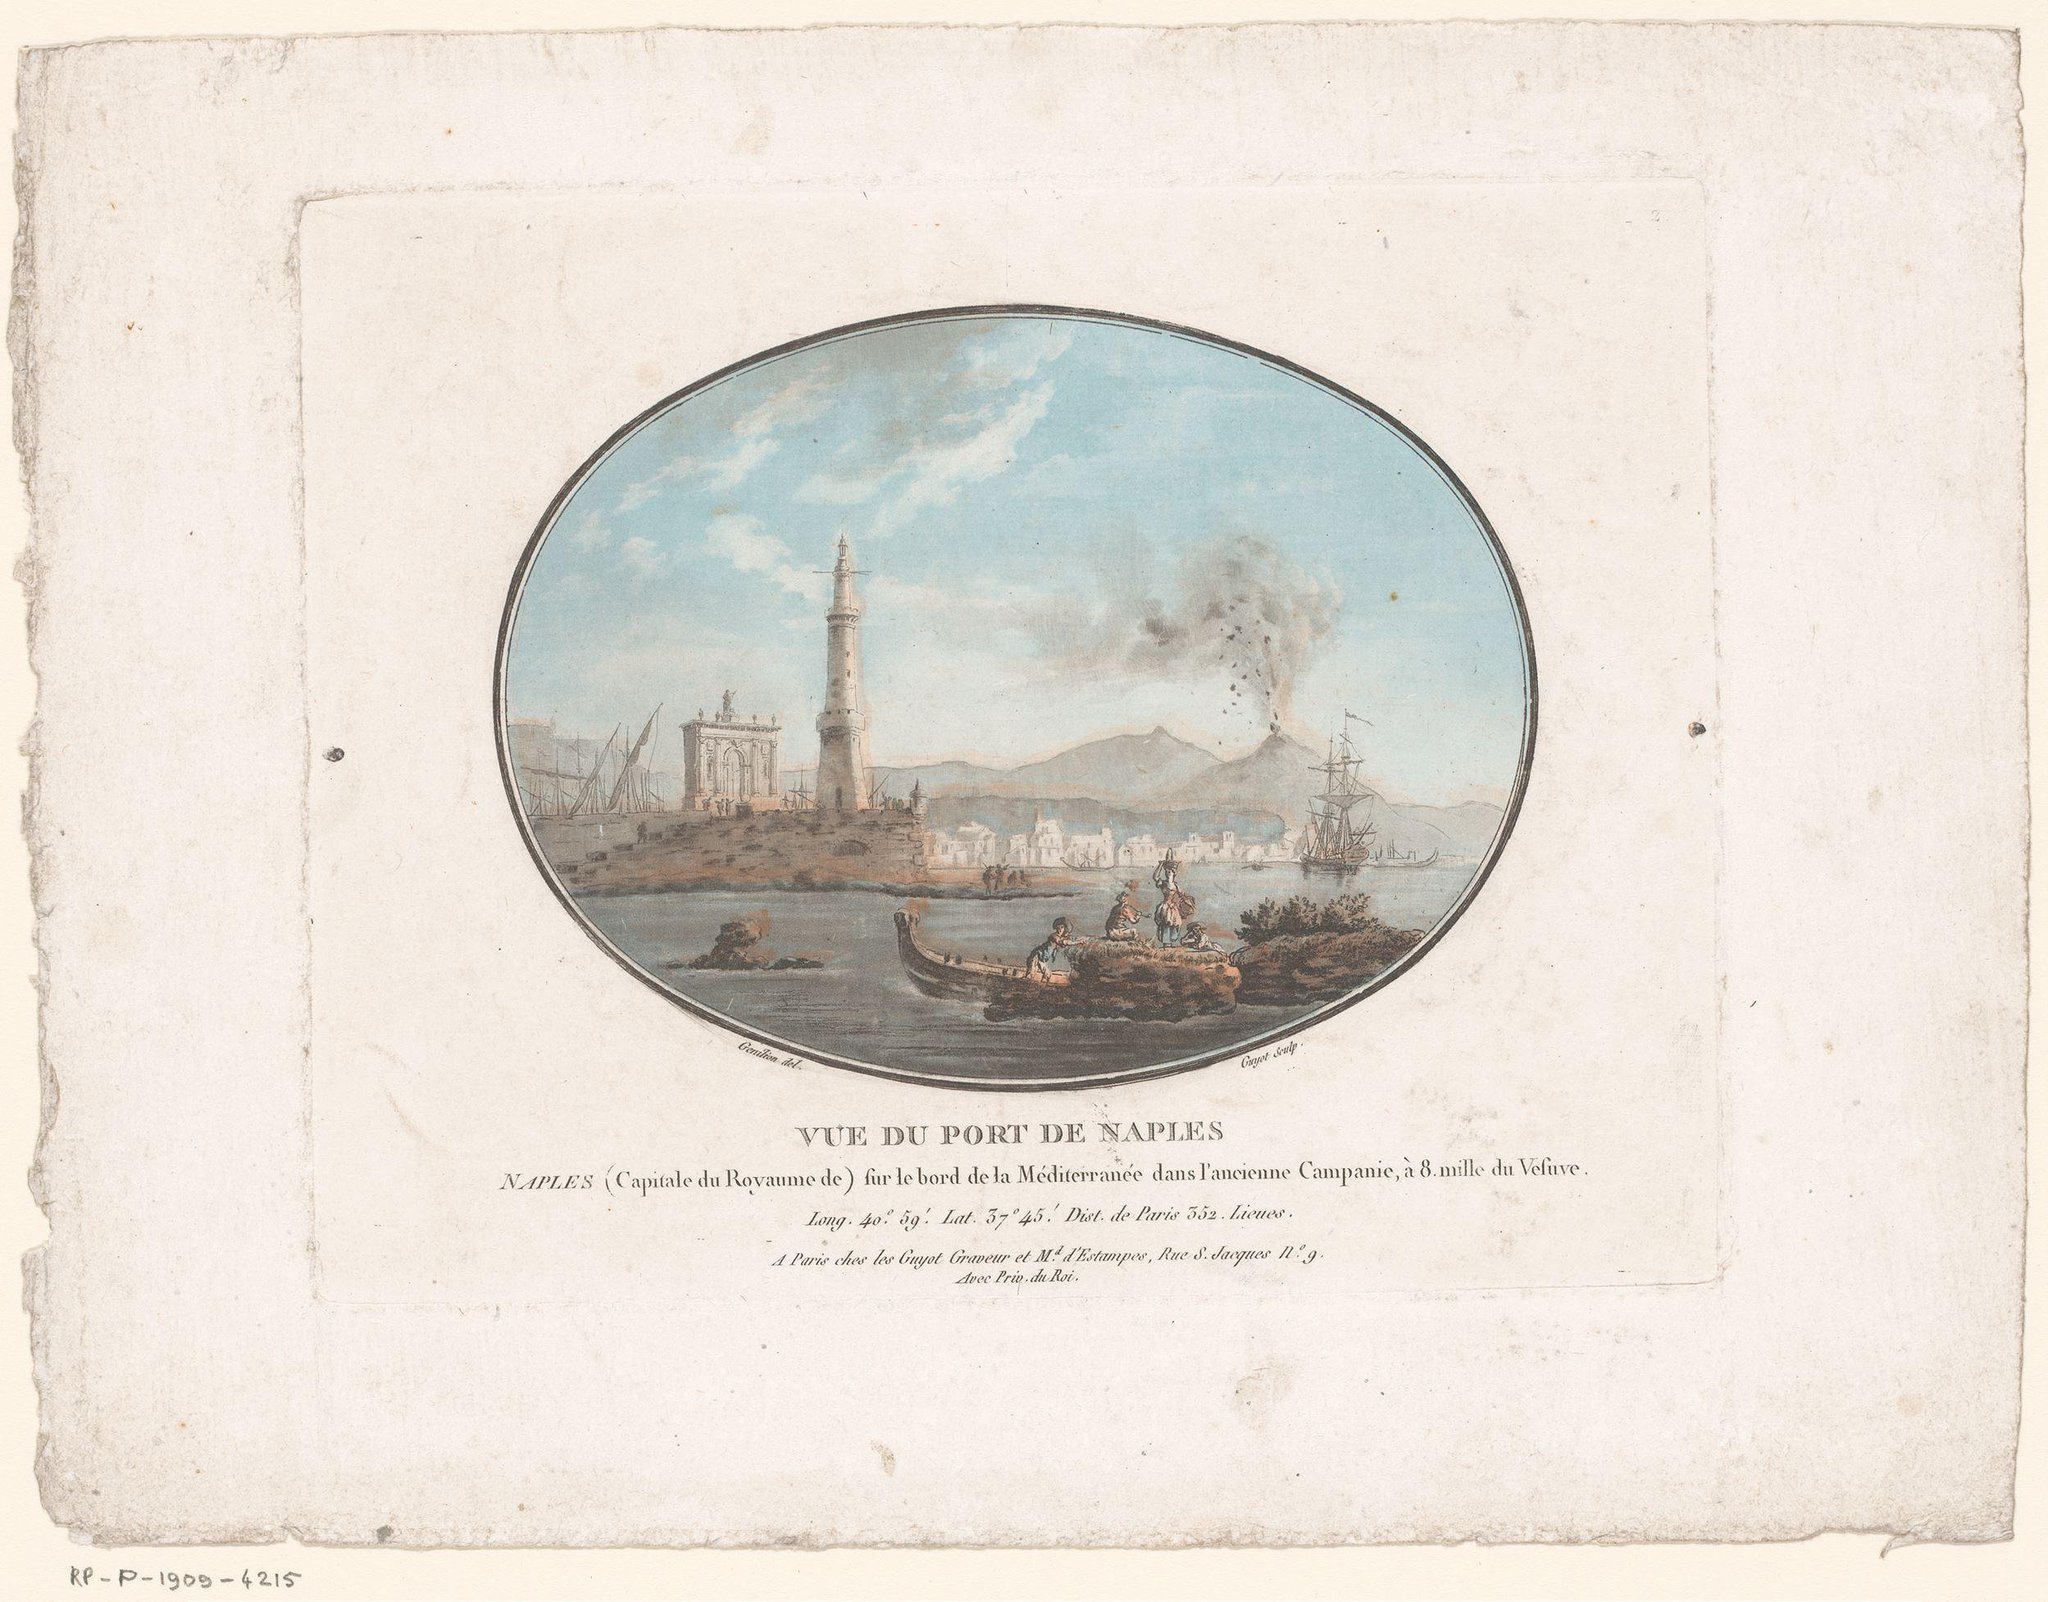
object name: print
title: Vues d'Italie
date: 1788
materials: paper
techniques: etching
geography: paris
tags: harbour, city-view in general; 'veduta', naples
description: Maakt deel uit van een tiendelige serie met gezichten op Italië, in ovale vorm. De eerste zes prenten van de serie werden aangekondigd in 'Journal de Paris', 14 februari 1788.